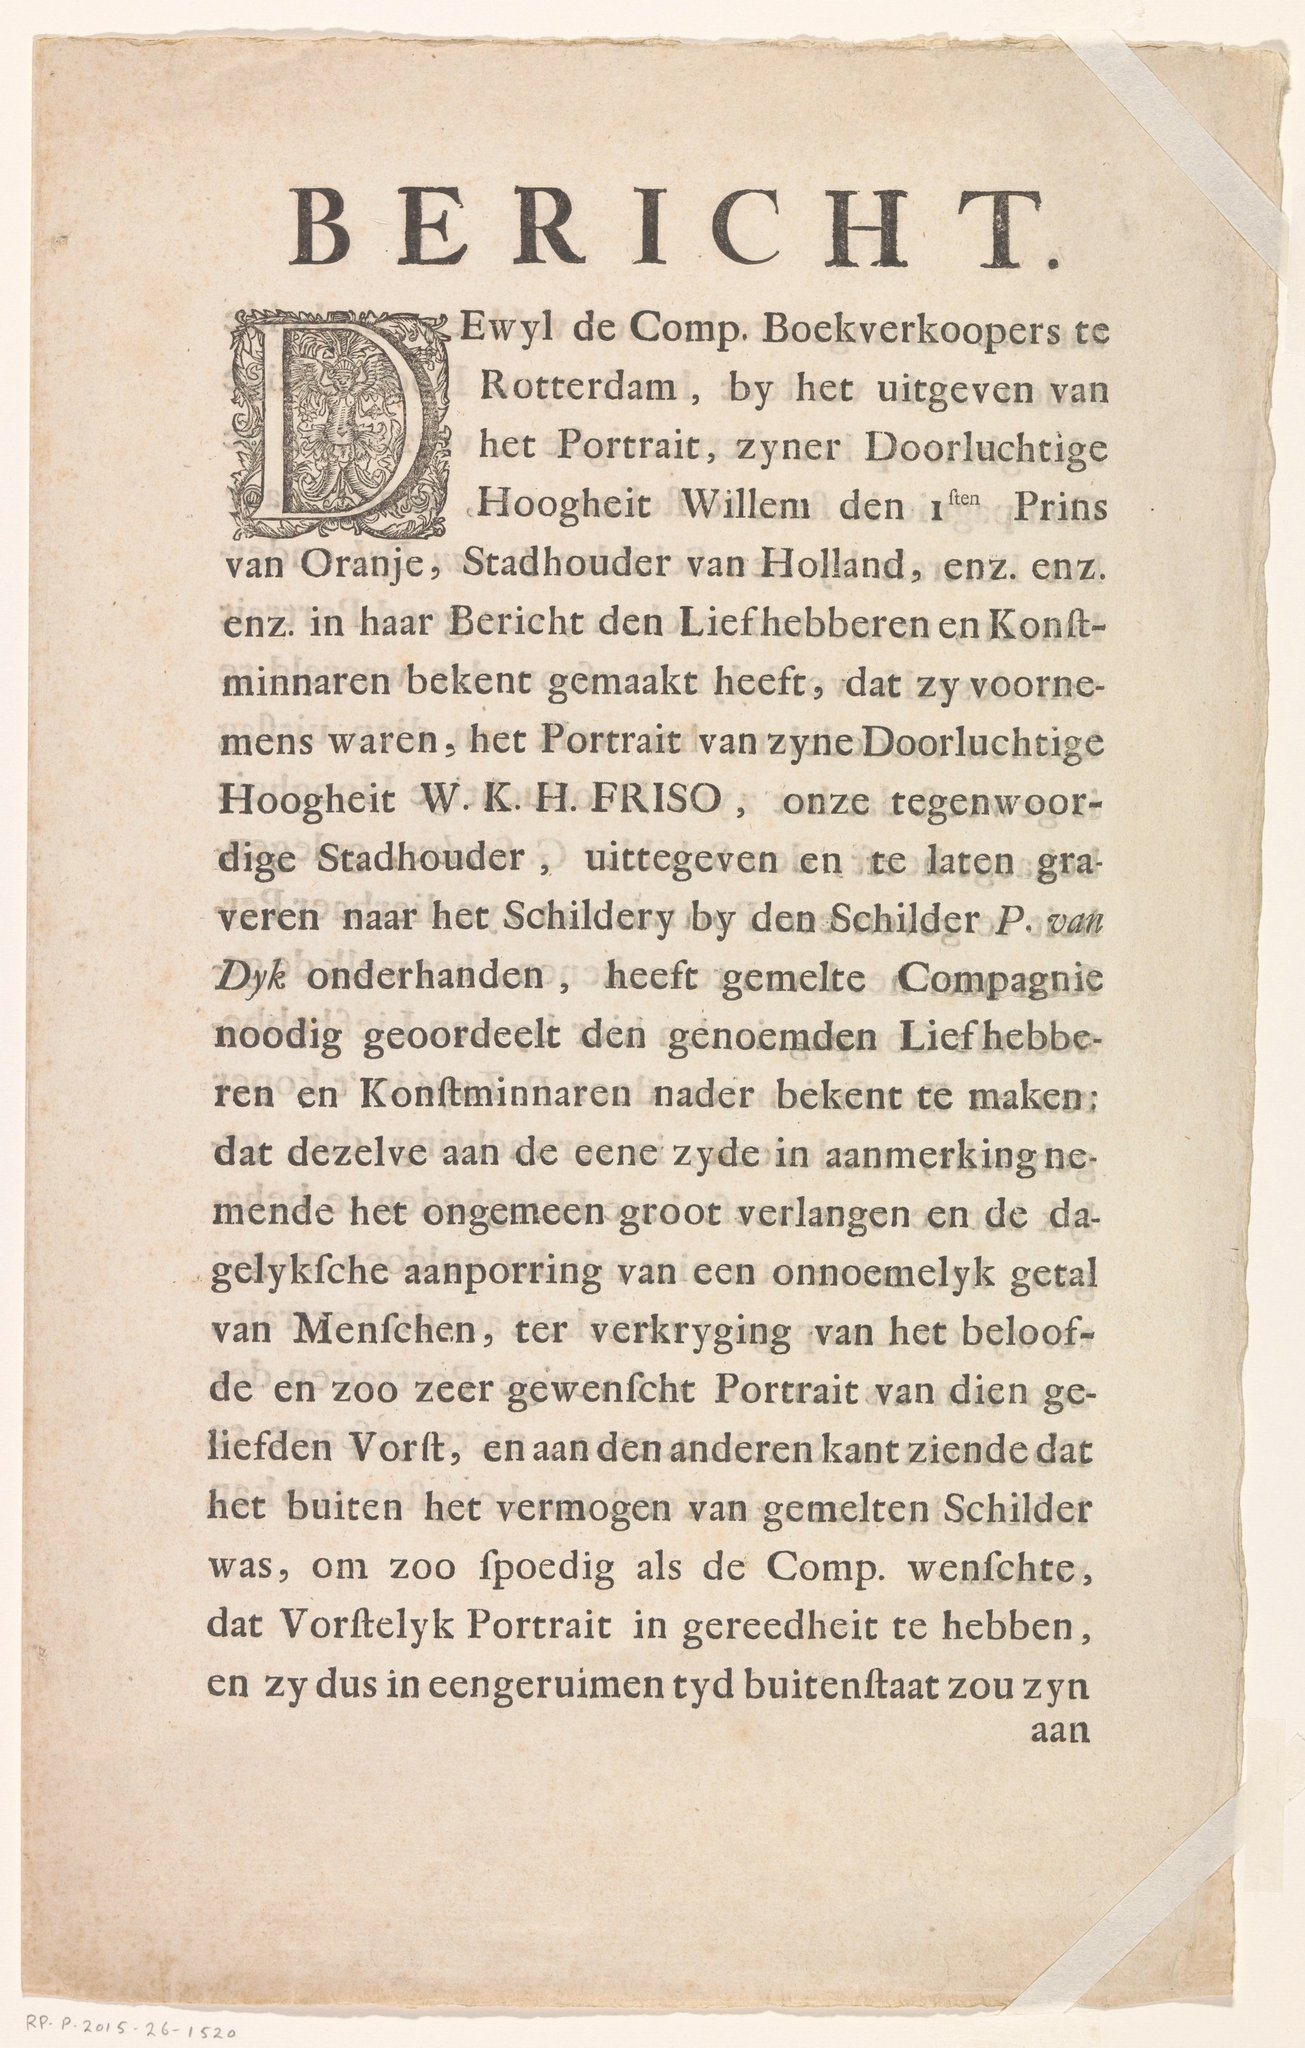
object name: print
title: Uitgeversprospectus voor een portret van Willem IV, prins van Oranje-Nassau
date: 1750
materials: paper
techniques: letterpress printing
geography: rotterdam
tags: initial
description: Uitgeversprospectus voor het portret van stadhouder Willem IV van Oranje-Nassau, gegraveerd door Pieter Tanjé naar een tekening van Gerard Sanders, uitgegeven door de Compagnie van boekverkopers in Rotterdam (Societ. Bibliopol. Rotterod.) in 1750 (zie: RP-P-OB-65.128). Uit de prospectus blijkt dat men oorspronkelijk van plan was om een schilderij van Philip van Dijck in prent te brengen. Toen duidelijk werd dat dit te lang zou duren werd Gerard Sanders benaderd.